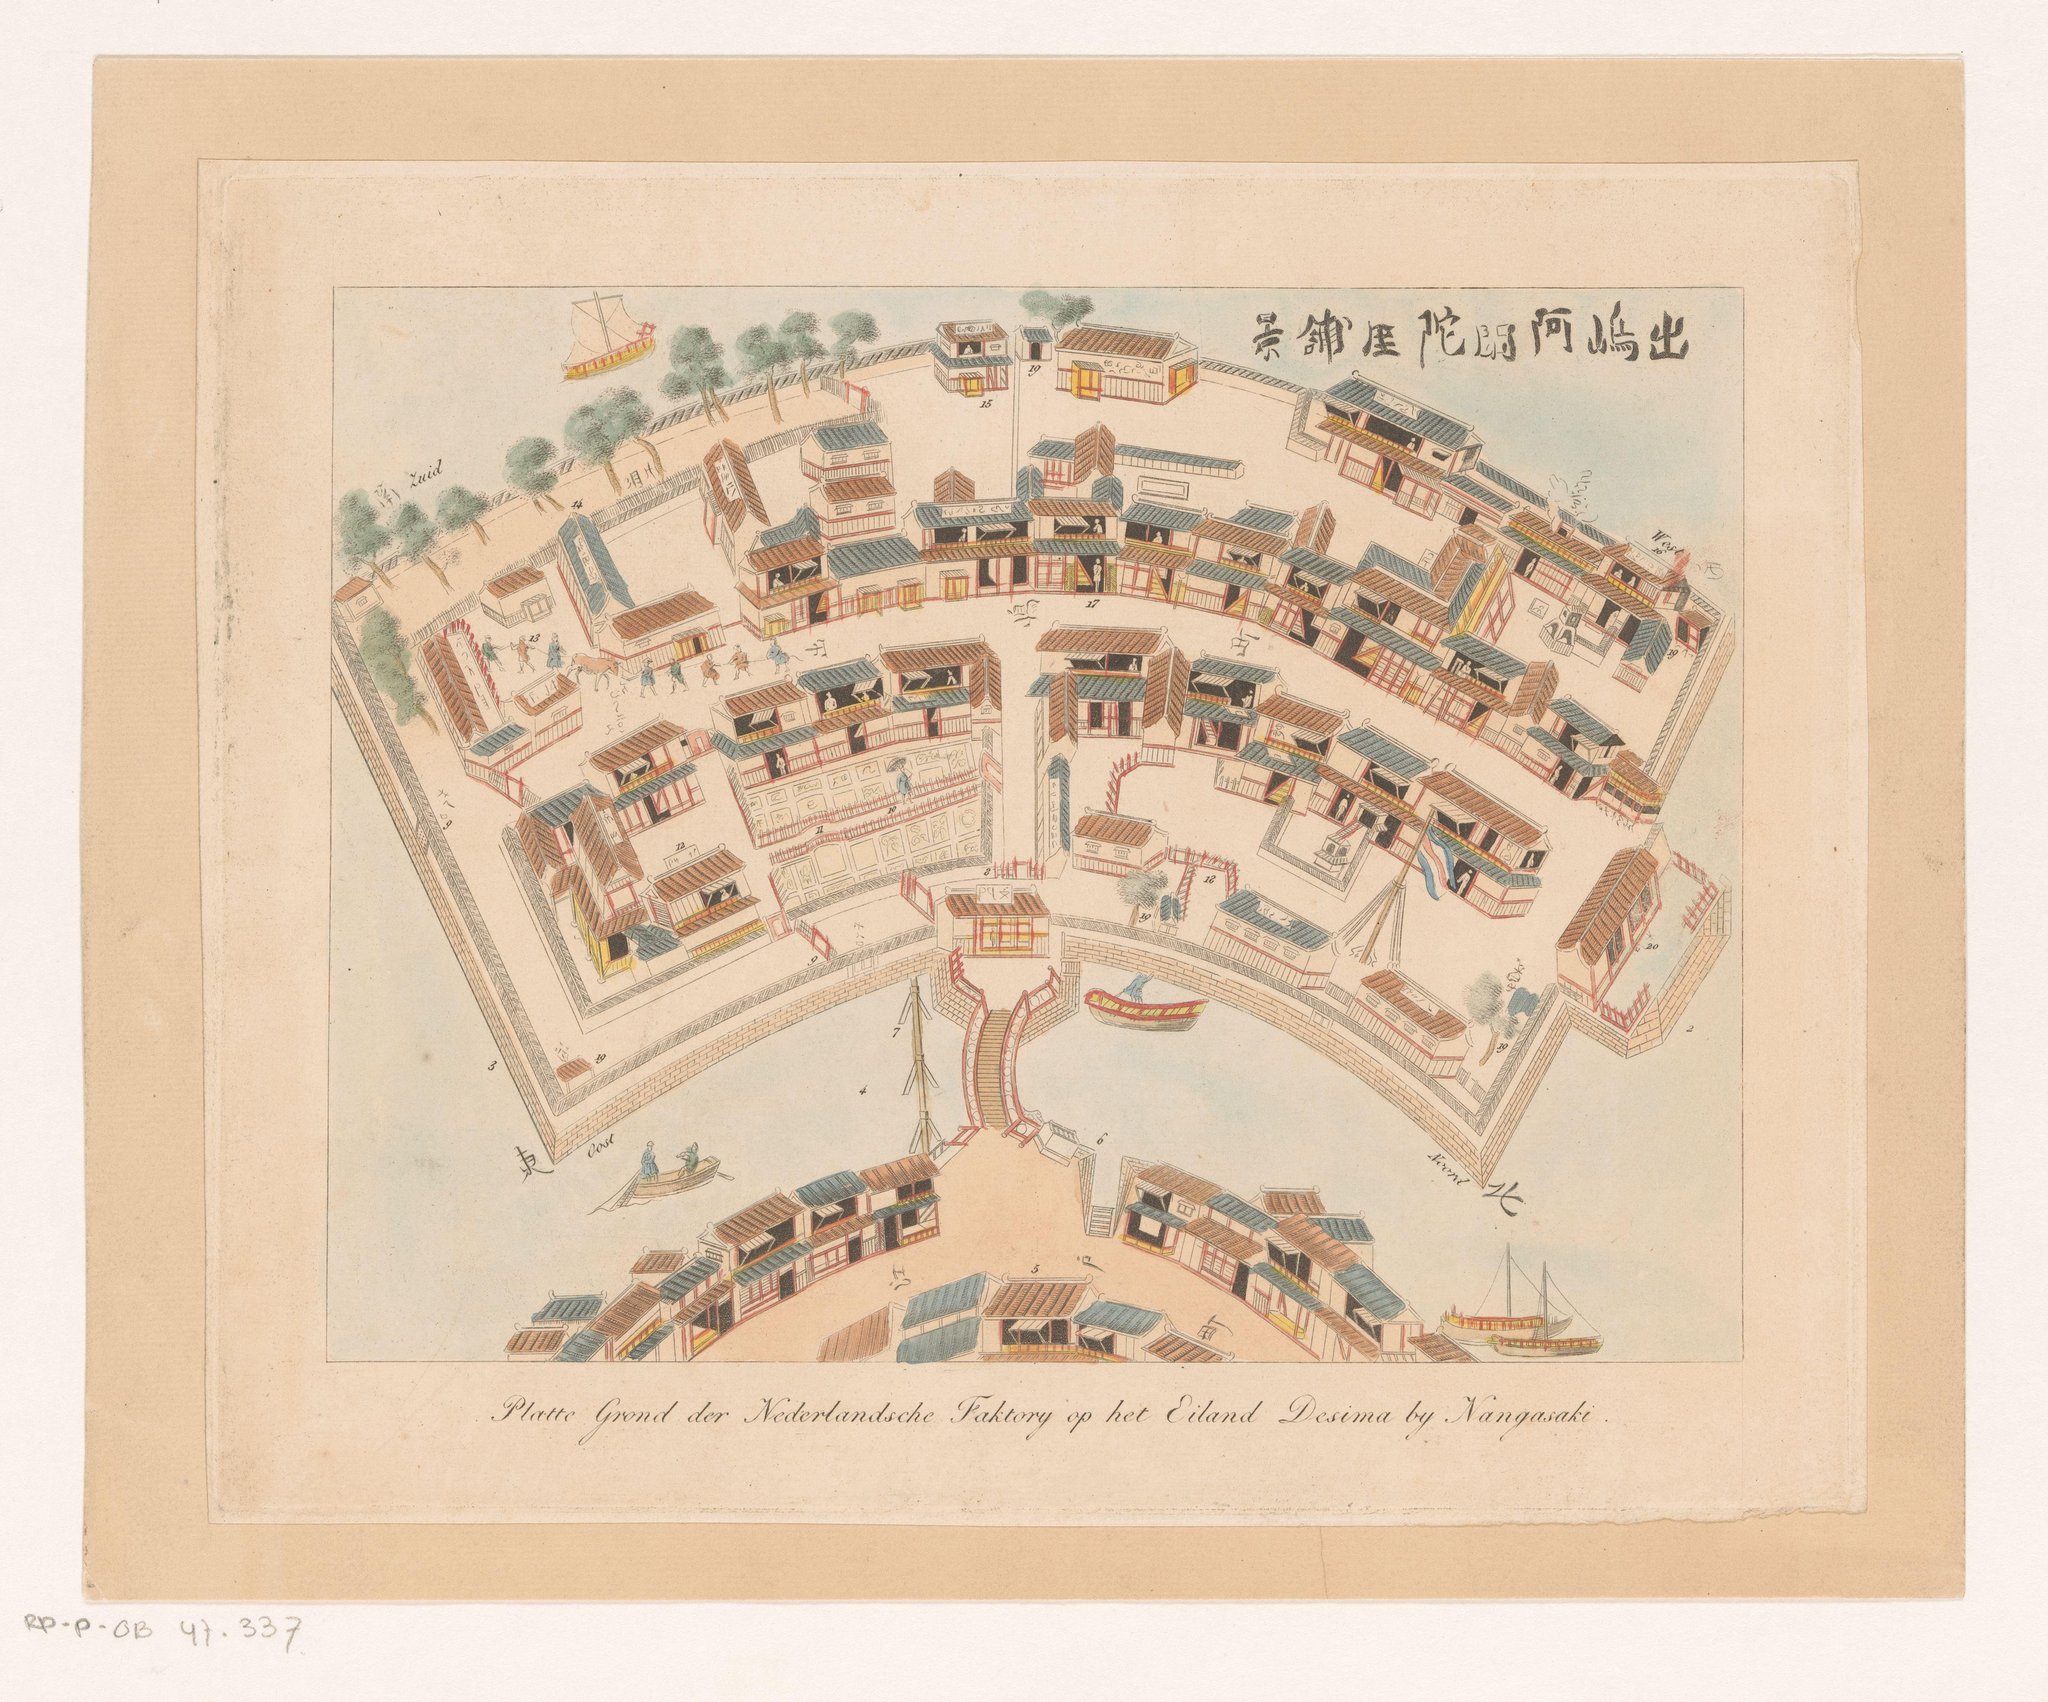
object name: print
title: Plattegrond van de Nederlandse handelspost Dejima bij Nagasaki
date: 1824-1825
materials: paper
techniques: engraving, hand coloring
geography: the hague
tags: maps of cities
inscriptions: collector's mark: Lugt 2228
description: uit: Titsingh, Isaac. Bijzonderheden over Japan (...). 2 dln. Den Haag: Weduwe J. Allart,1824-1825, dl. 2, p. 264.